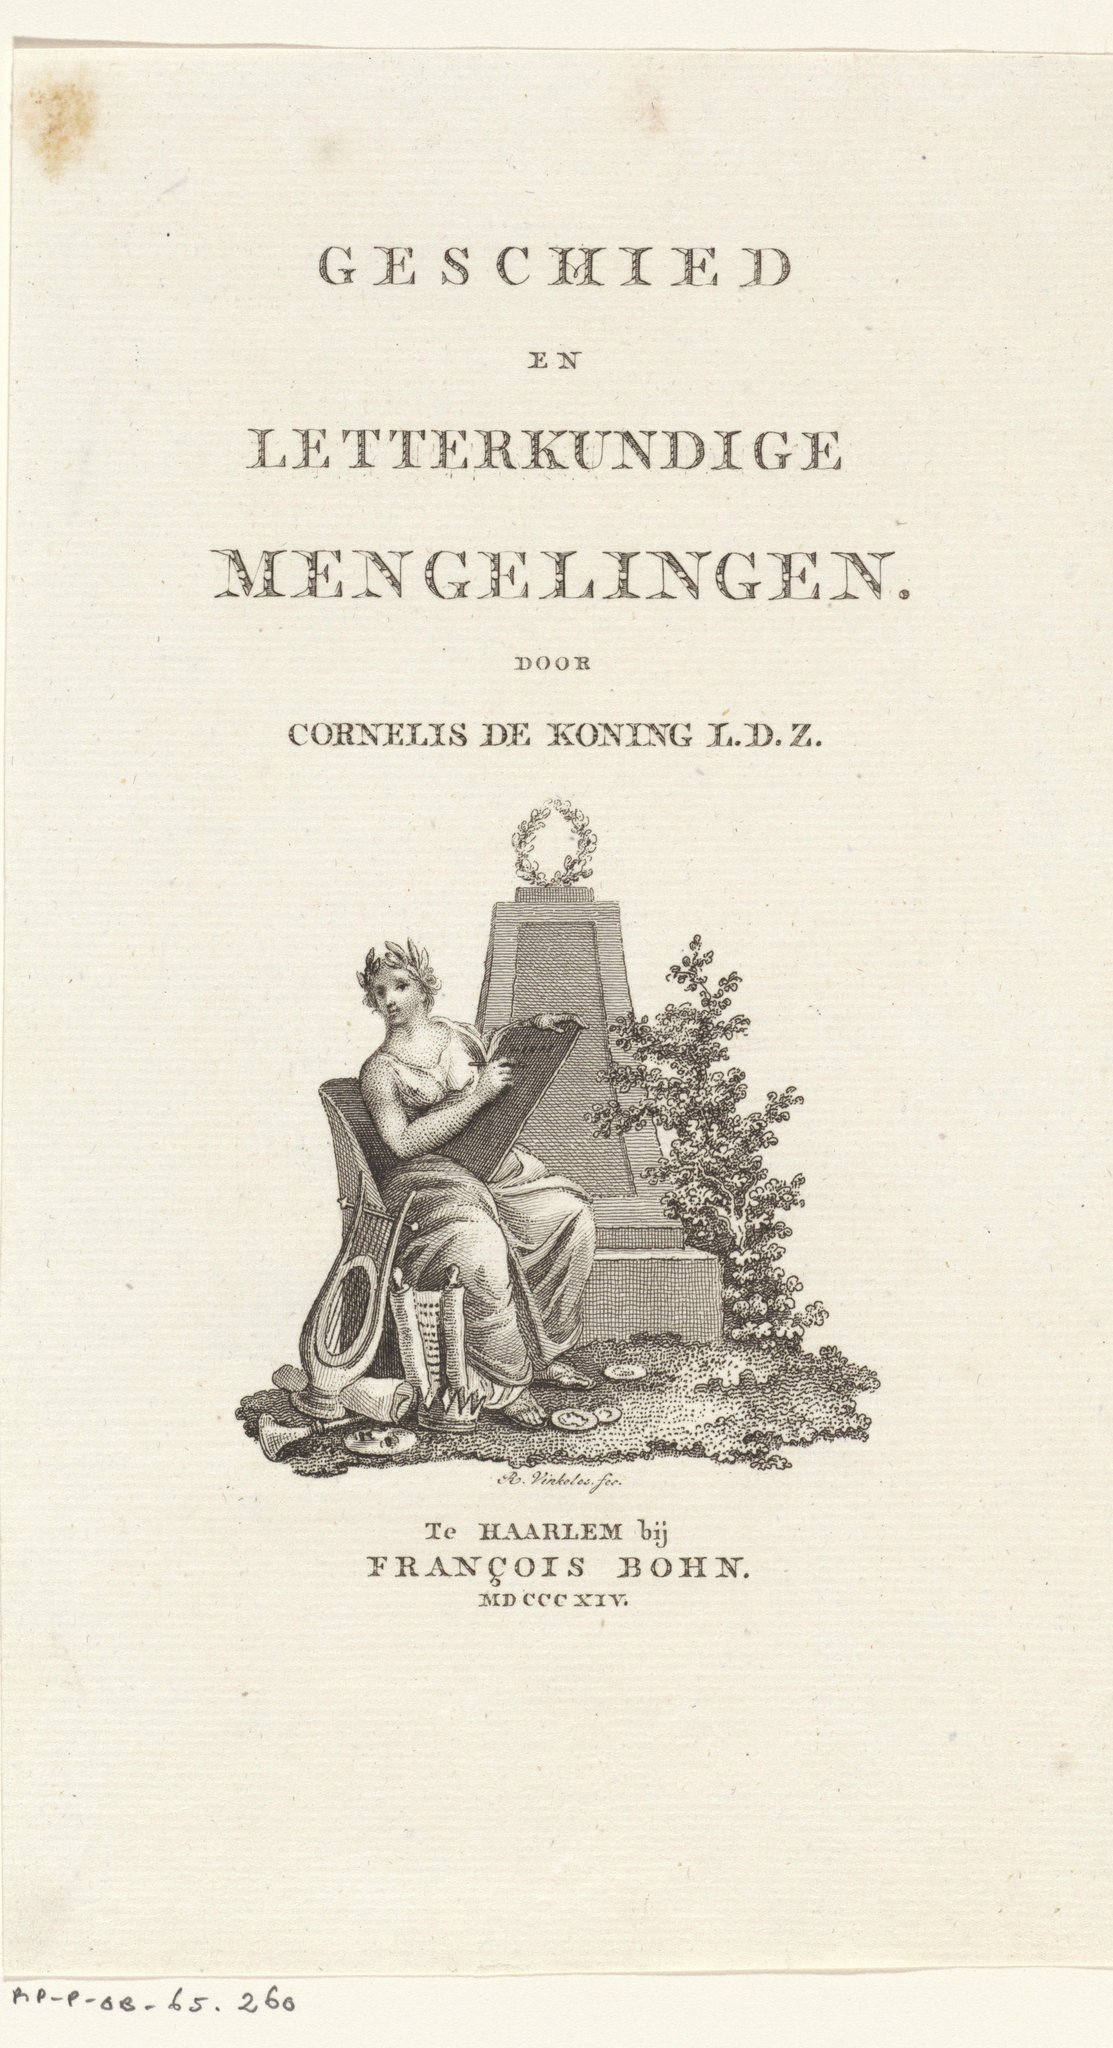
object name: print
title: Titelpagina voor: C. de Koning ' Geschied en letterkundige mengelingen', 1814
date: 1814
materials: paper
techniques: engraving, etching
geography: haarlem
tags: handwriting, writing as activity, 'historia'; 'historia' (ripa) (+ variant), harp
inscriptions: collector's mark: Lugt 2228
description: Titelpagina voor: Koning, Cornelis Leendertsz. de. Geschied en letterkundige mengelingen. Haarlem: François Bohn, 1814.